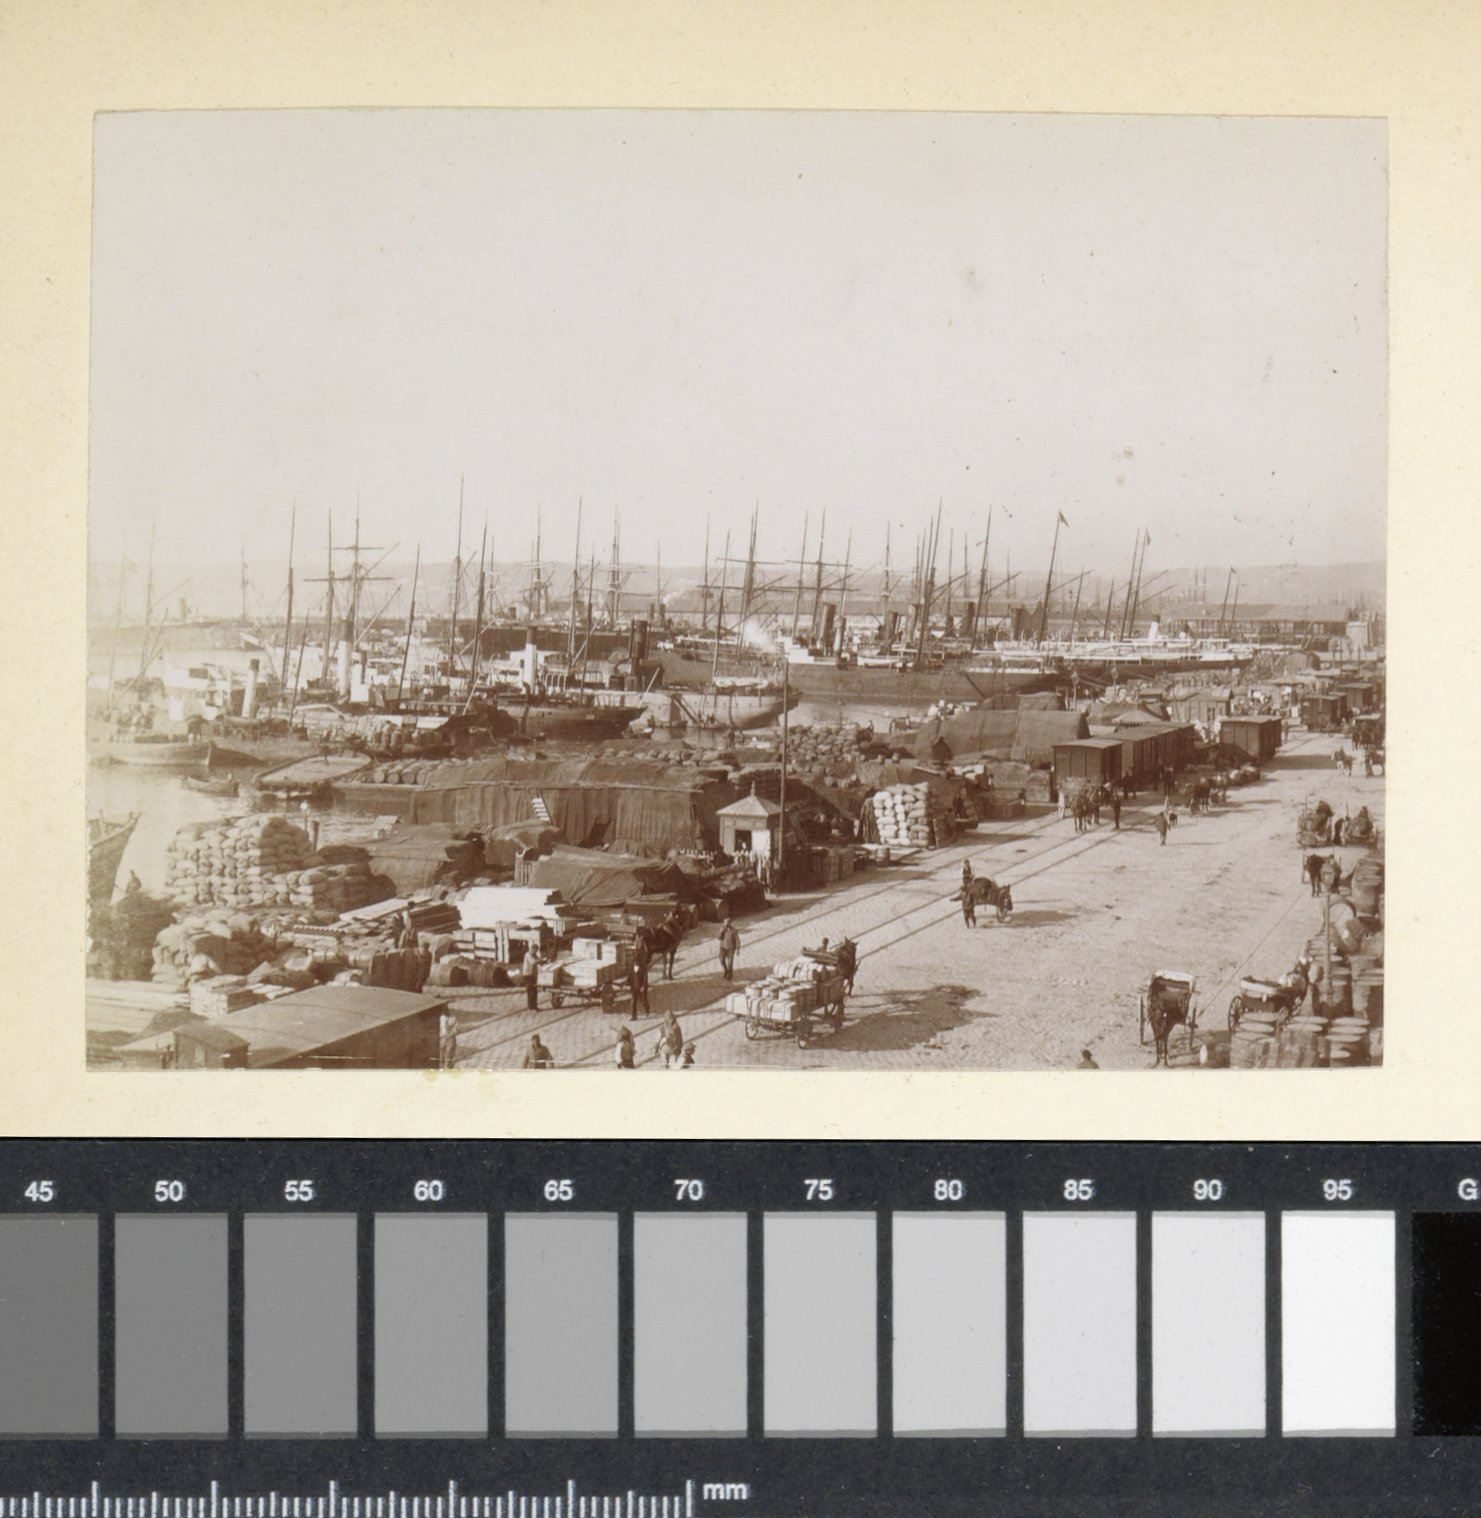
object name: photograph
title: Gezicht op havenkades, vermoedelijk in Marseille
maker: Anonymous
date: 1900-1910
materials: paper, photographic support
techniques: daylight paper print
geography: marseille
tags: harbour (+ view ~ vehicle, ship, etc.), quay (+ city(-scape) with figures, staffage), marseille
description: Onderdeel van Fotoalbum van een Franse amateurfotograaf met opnames van een familie, distilleerderij Delizy & Doistau Fils, het leger en bezienswaardigheden in Frankrijk.